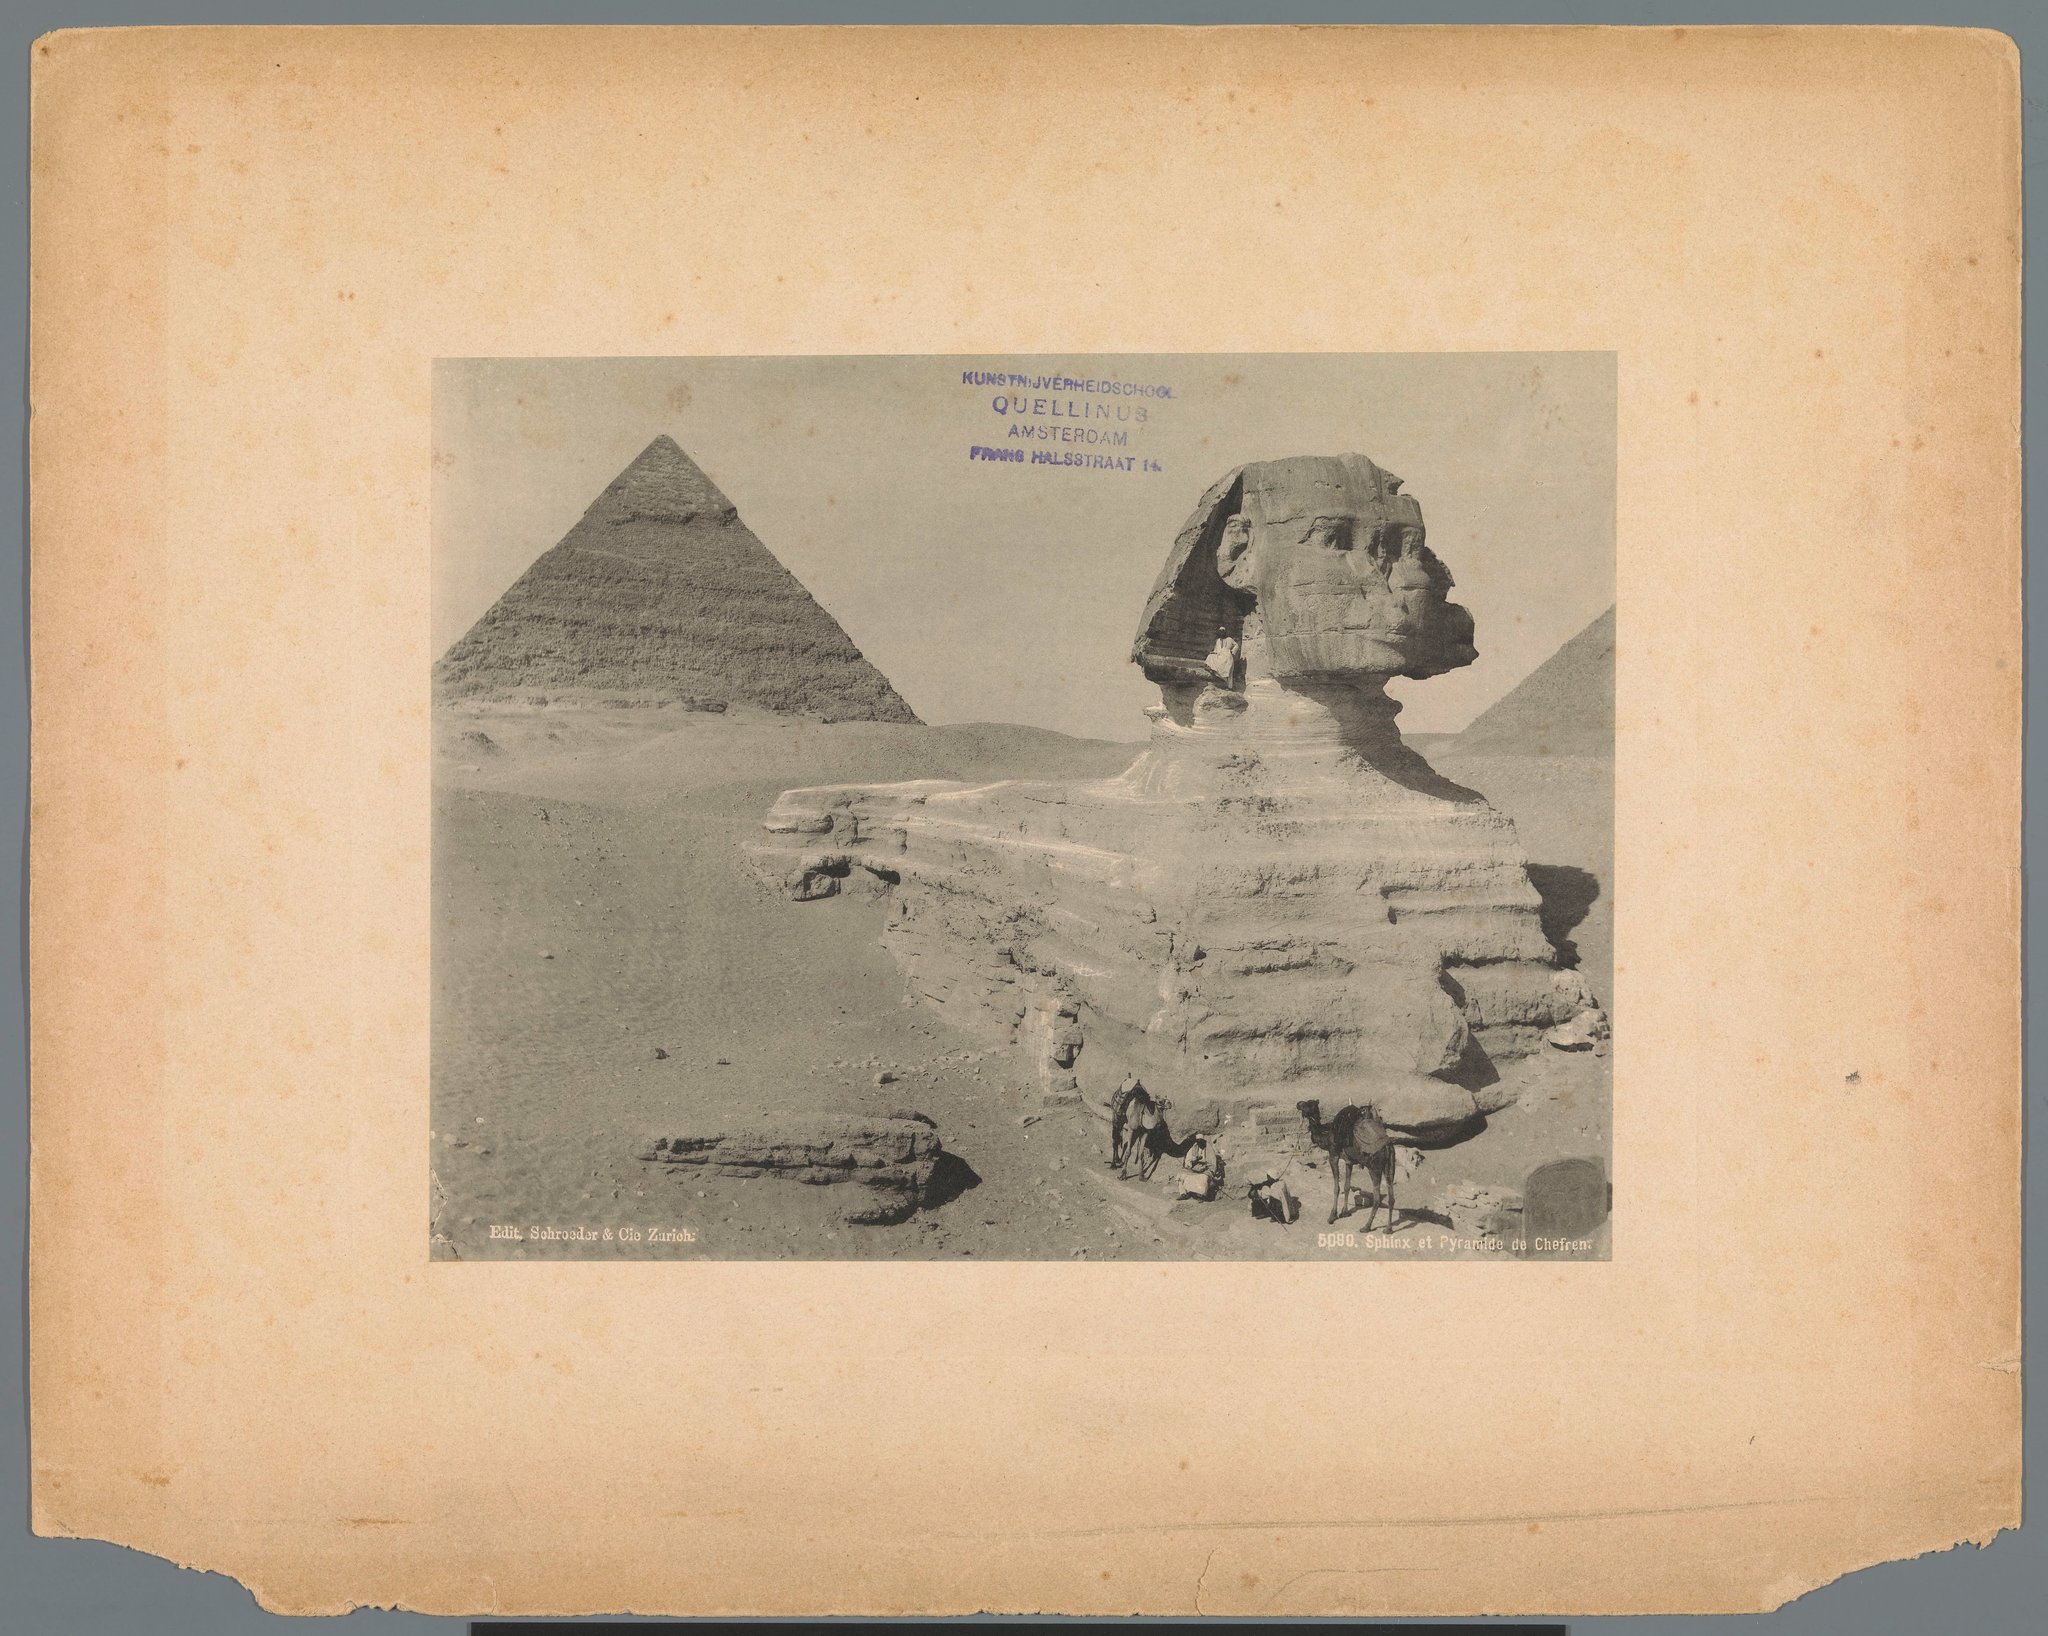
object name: photograph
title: Piramide van Chefren en de Sfinx van Gizeh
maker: Anonymous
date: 1875-1900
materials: cardboard, ink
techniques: photograph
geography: gizeh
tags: hoofed animals: camel, sphinx (lion/woman); 'sfinge' (ripa), quadrangular pyramid, desert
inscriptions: number: ‘5090.’, collector's mark: ‘INSTITUUT VOOR KUNST- NIJVERHEIDSONDERWIJS GABRIËL METSUSTRAAT No. 16. AMSTERDAM’, collector's mark: ‘KUNSTNIJVERHEIDSCHOOL QUELLINUS AMSTERDAM FRANS HALSSTRAAT 14.’